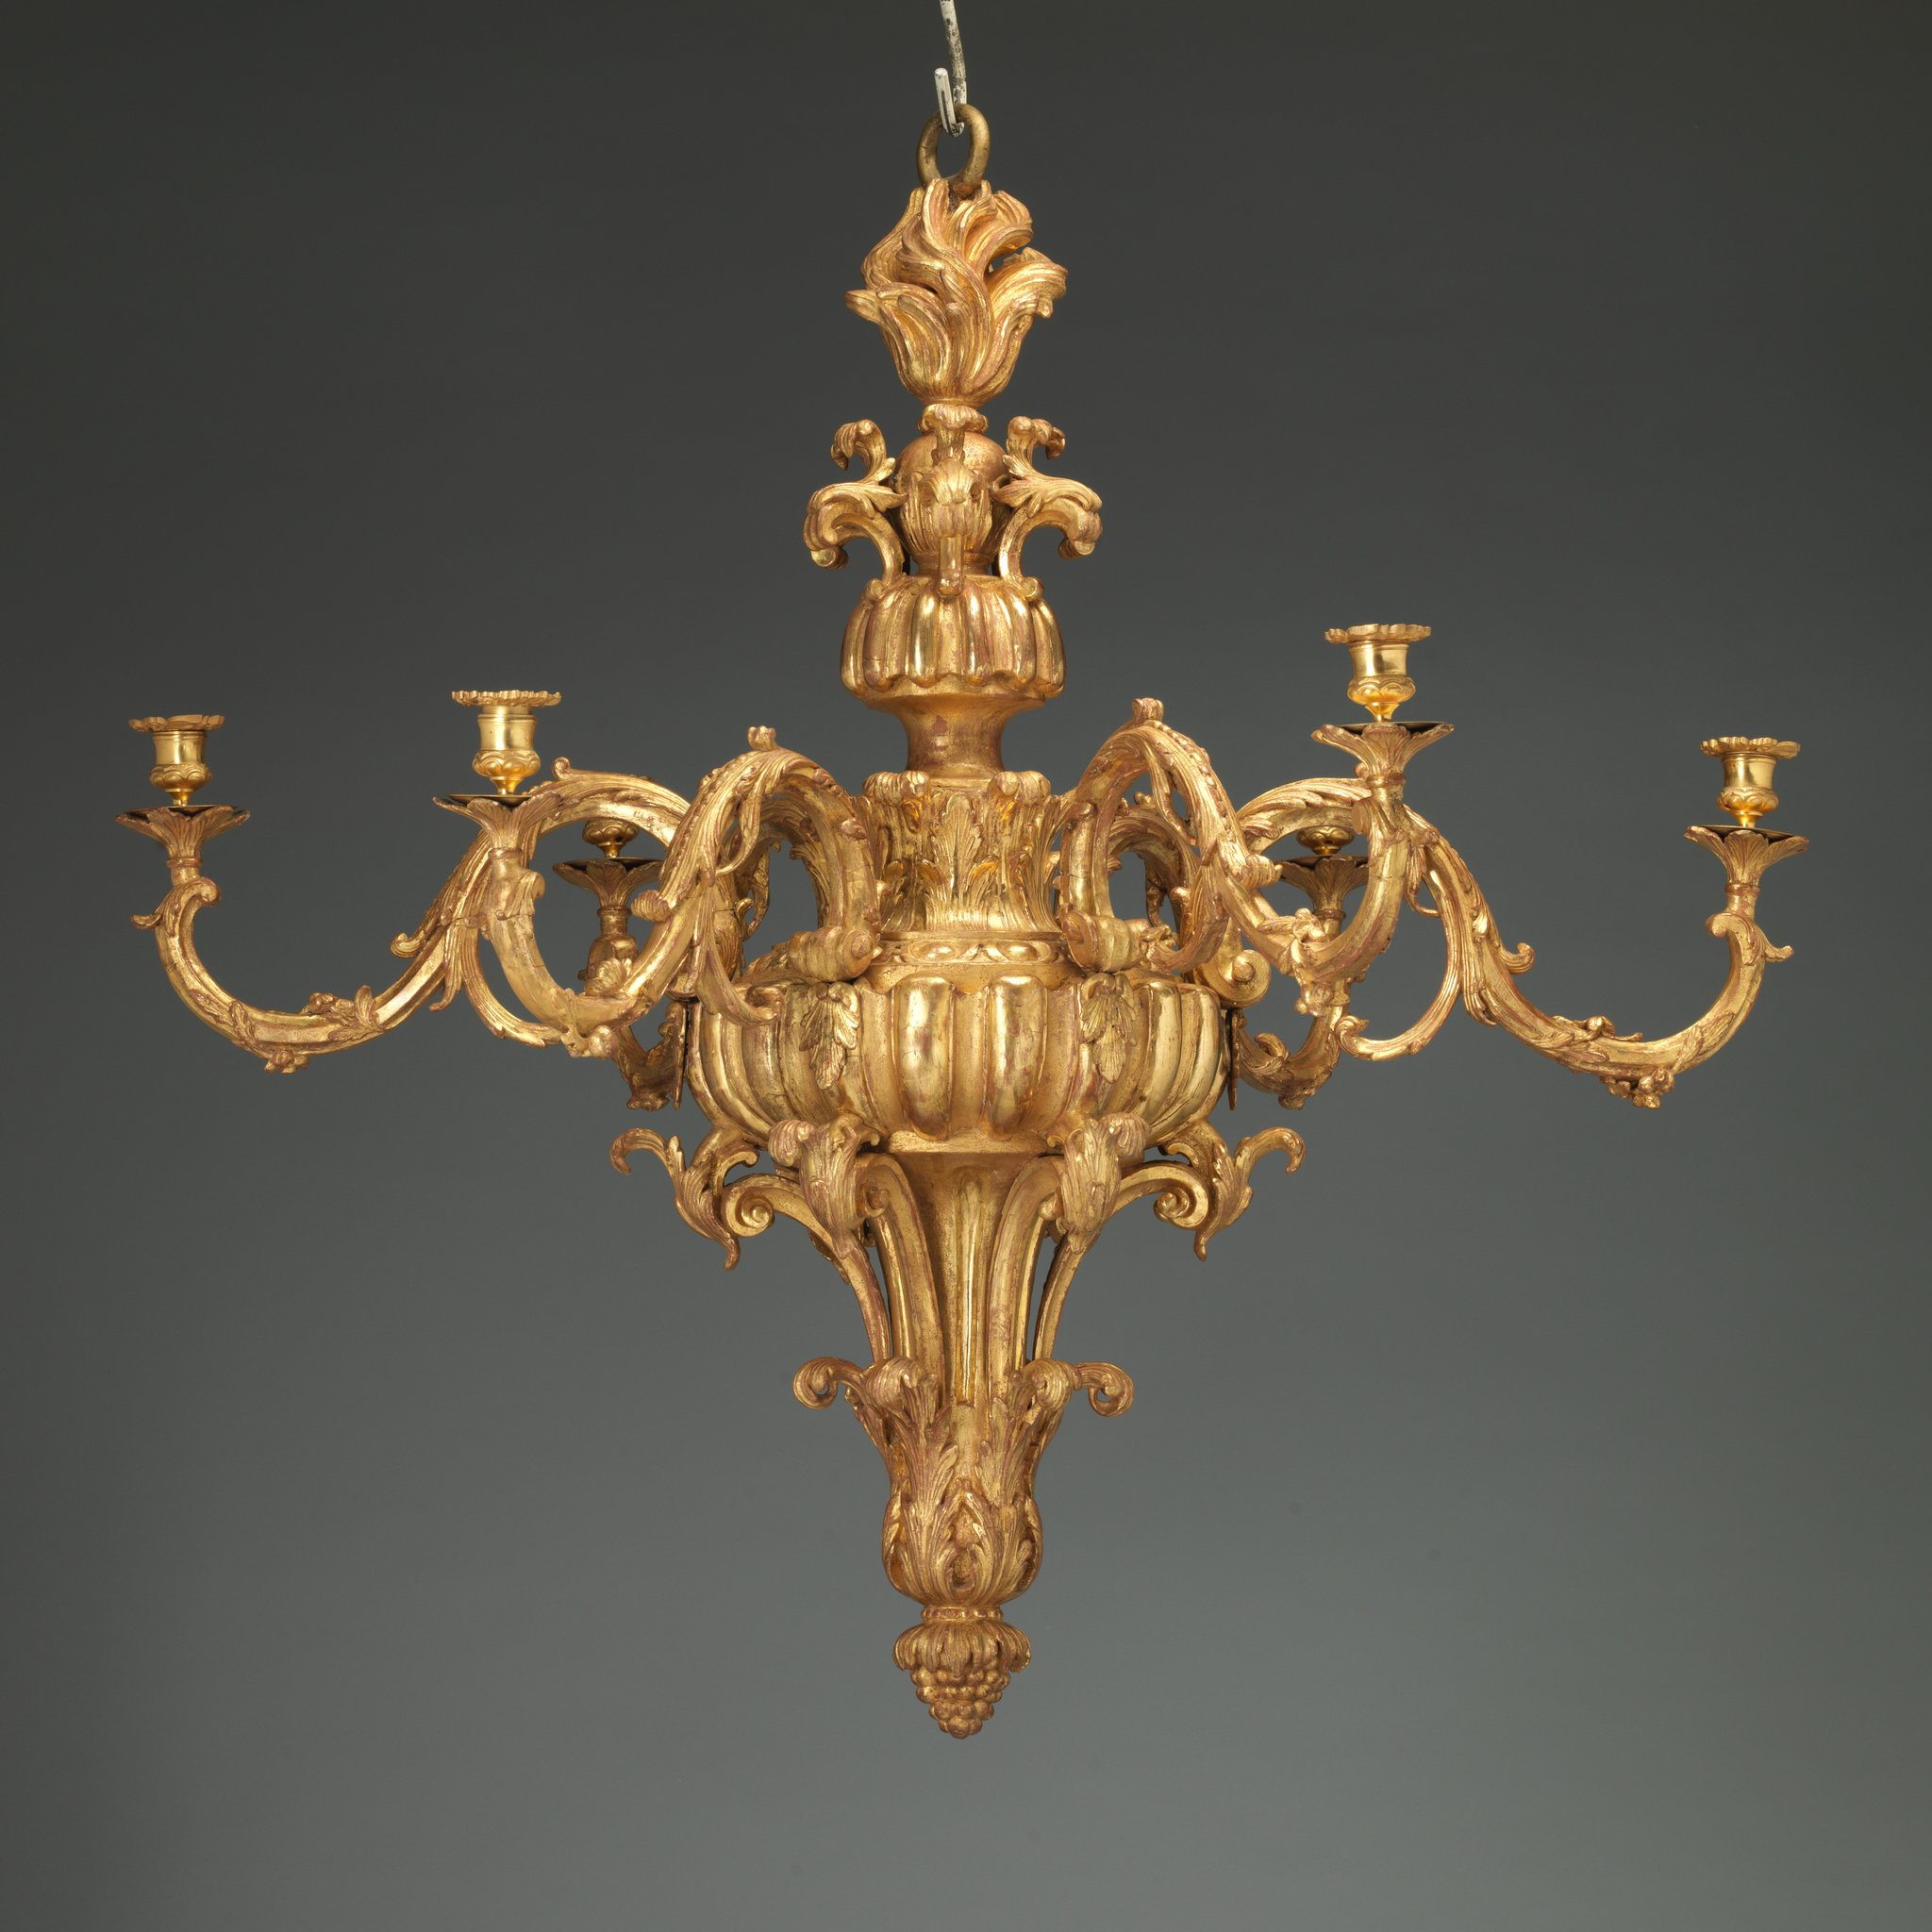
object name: chandelier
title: Six-branch chandelier (one of a pair)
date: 1725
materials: gesso, gilt bronze, wood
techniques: gilding